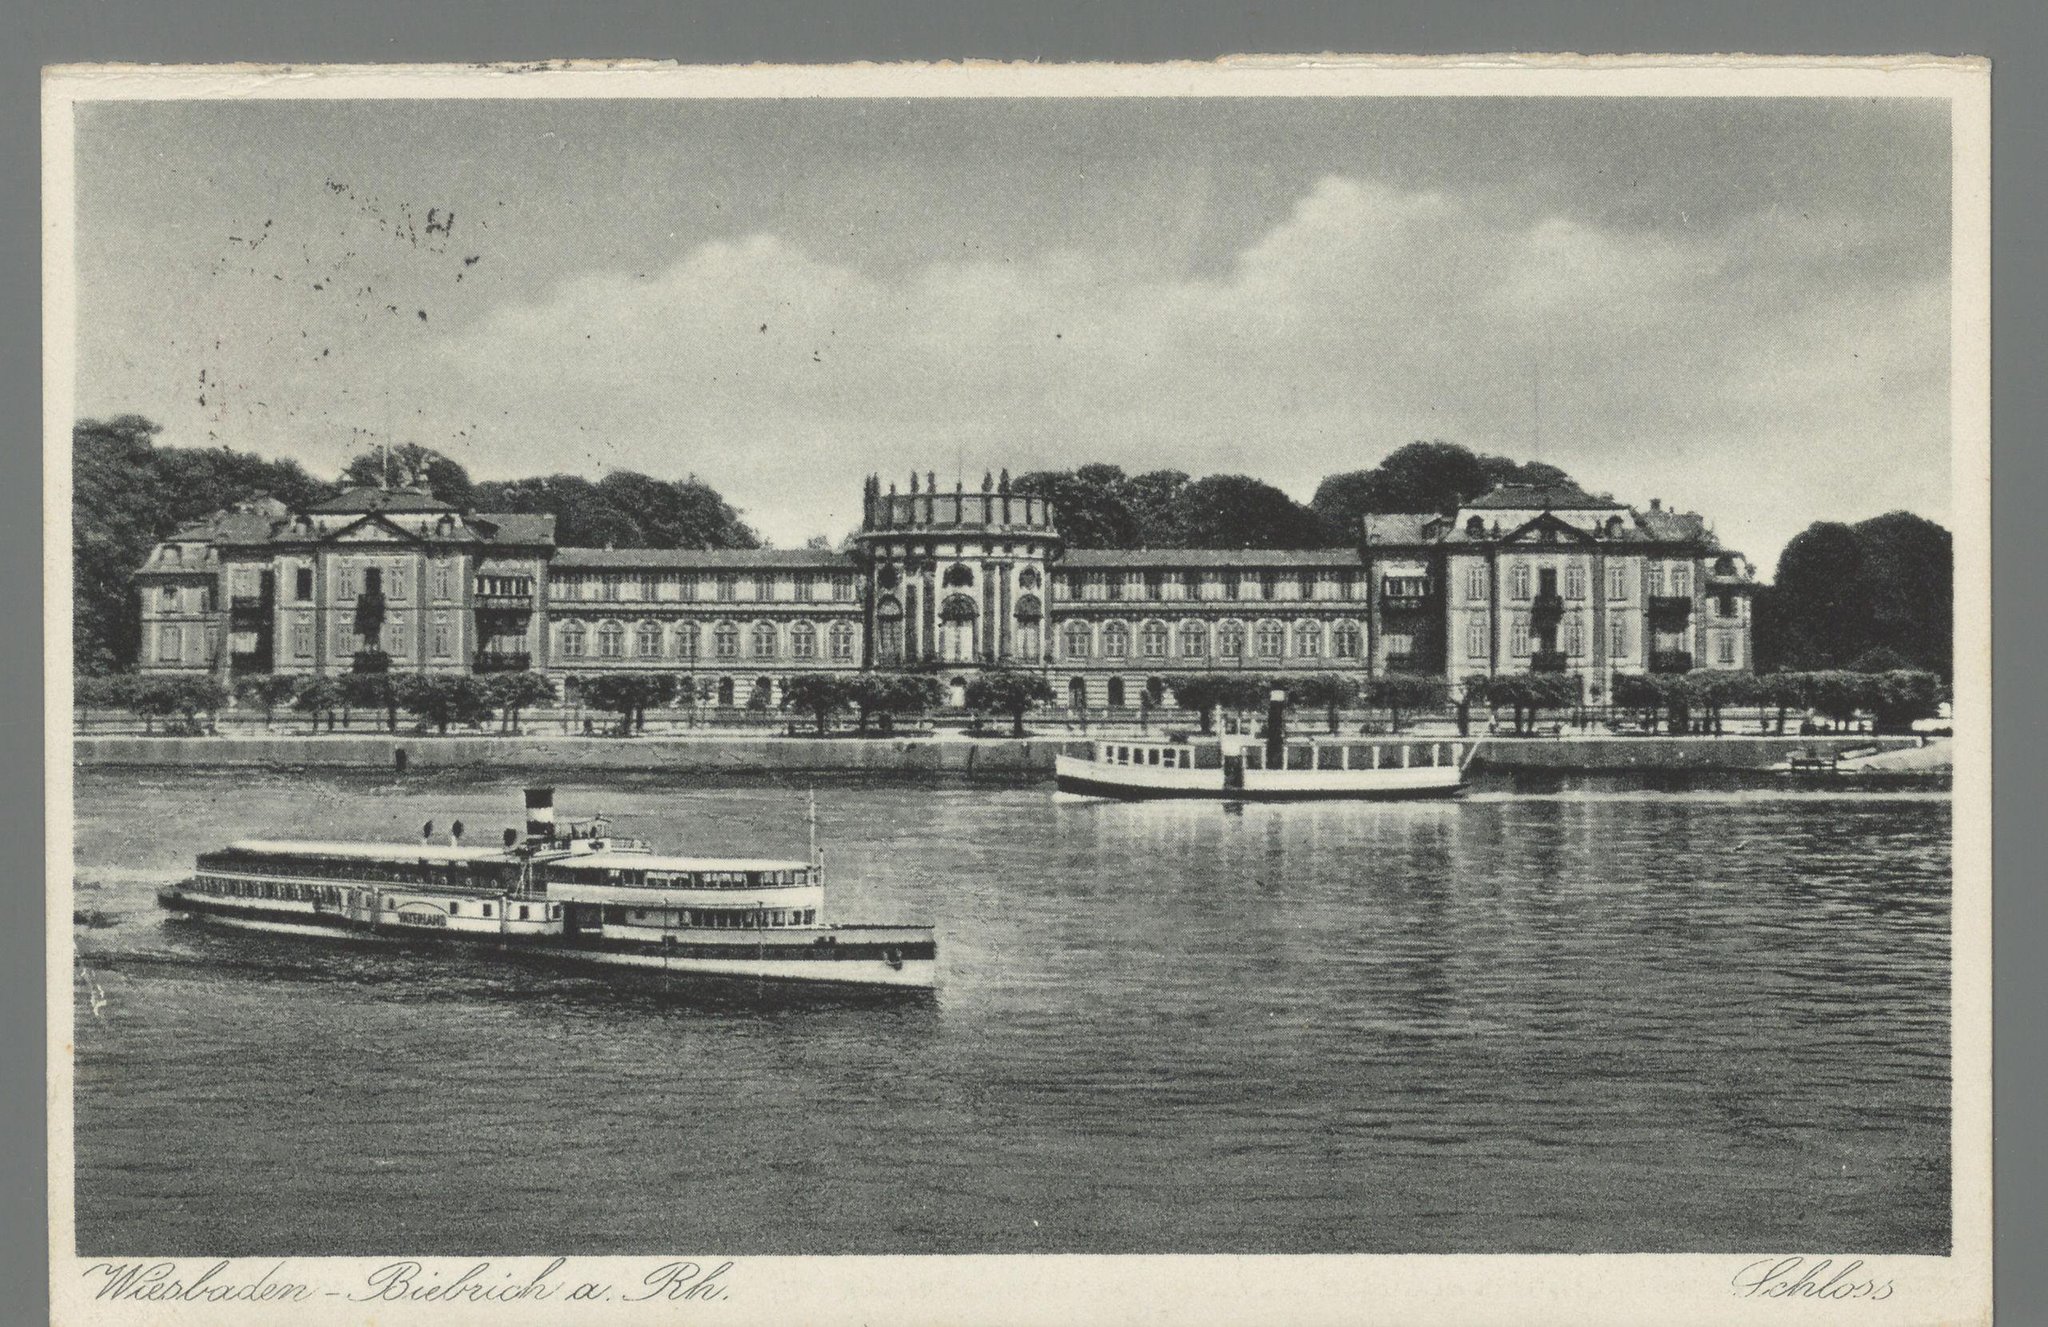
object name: ansichtkaart, prentbriefkaart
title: Wiesbaden - Biebrich a Rh. Schloss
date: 1905-1934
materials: cardboard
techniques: rotogravure, writing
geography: wiesbaden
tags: castle, canals, waters (in city)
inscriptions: postage stamp